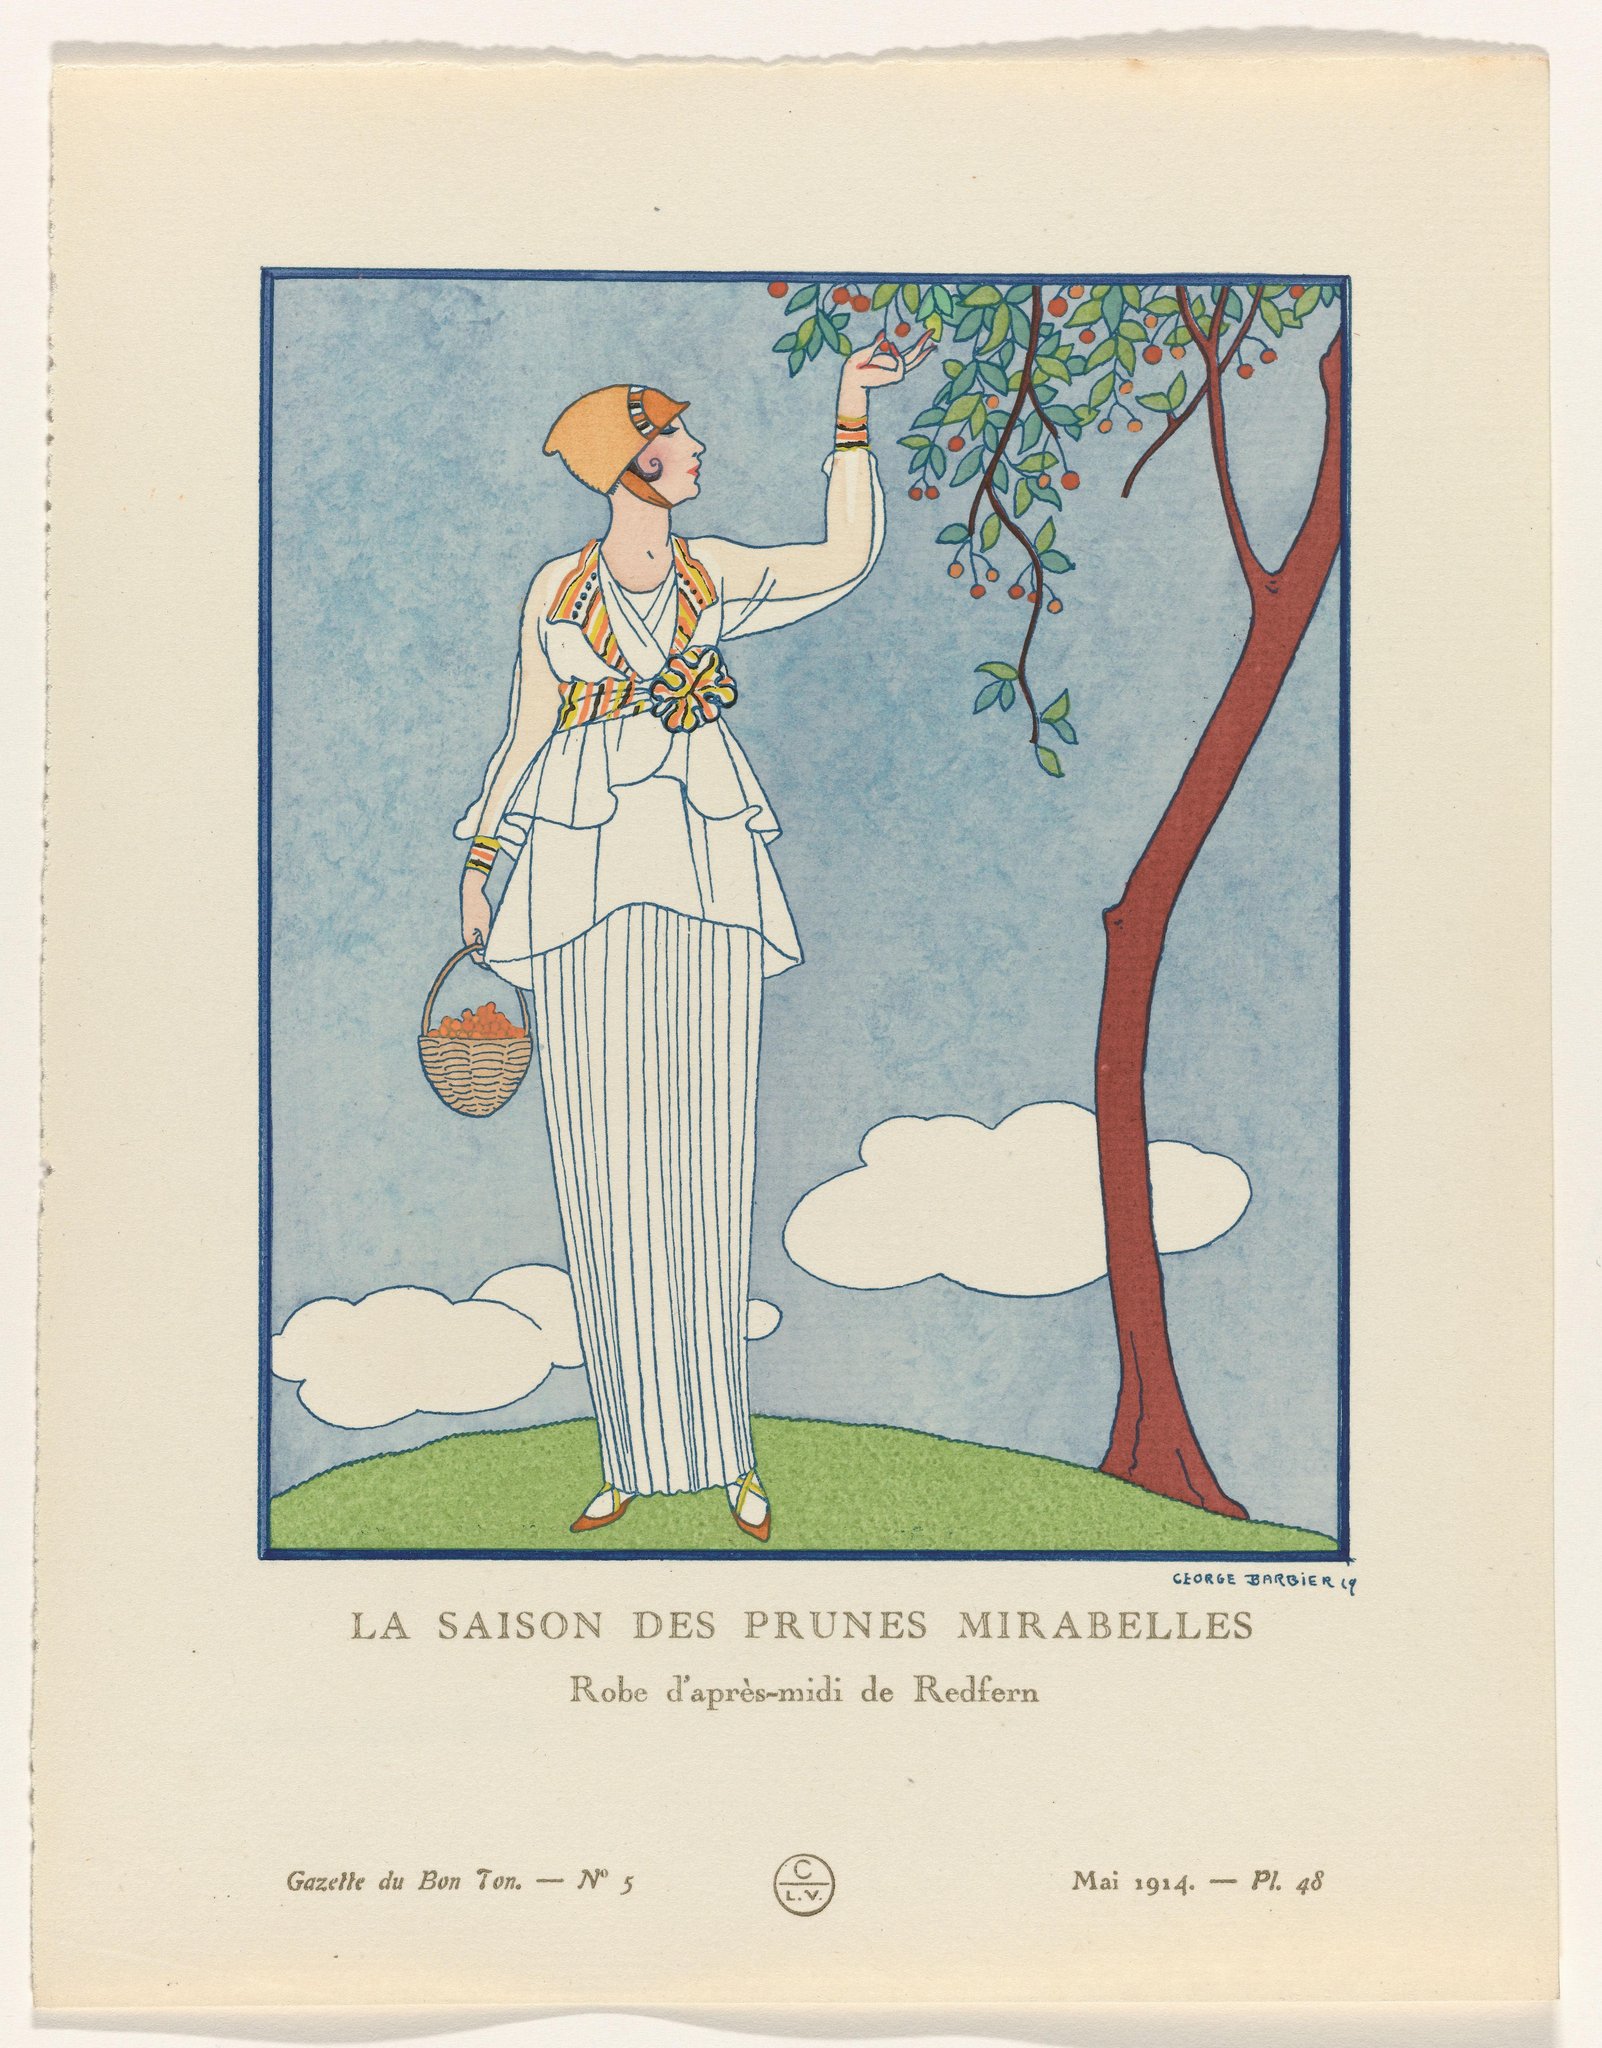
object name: fashion print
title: Gazette du Bon Ton. Art – Modes & Frivolités: Famous Fashion Houses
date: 1914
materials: paper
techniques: hand coloring, letterpress printing, lithograph, pochoir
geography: paris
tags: picking fruit (+ forms of production and organization), head-gear (+ women's clothes), fashion plates, dress, gown (+ women's clothes)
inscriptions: date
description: In 1912 the ambitious publisher Lucien Vogel decided to launch an exclusive magazine. Well-acquainted with the fashion world, he forged ties with several of most renowned fashion houses of Paris and gathered the crème de la crème of French illustrators for his project. They recorded the latest creations of designers such as Doeuillet, Doucet, Worth, Poiret and Redfern, and, later on, couture by Chéruit, Beer, Paquin and Lanvin. These designs were issued as separate plates. The Gazette was aimed at a small, extremely wealthy readership: in 1912-1913, a subscription for twelve issues cost an equivalent of around 400 euros today.